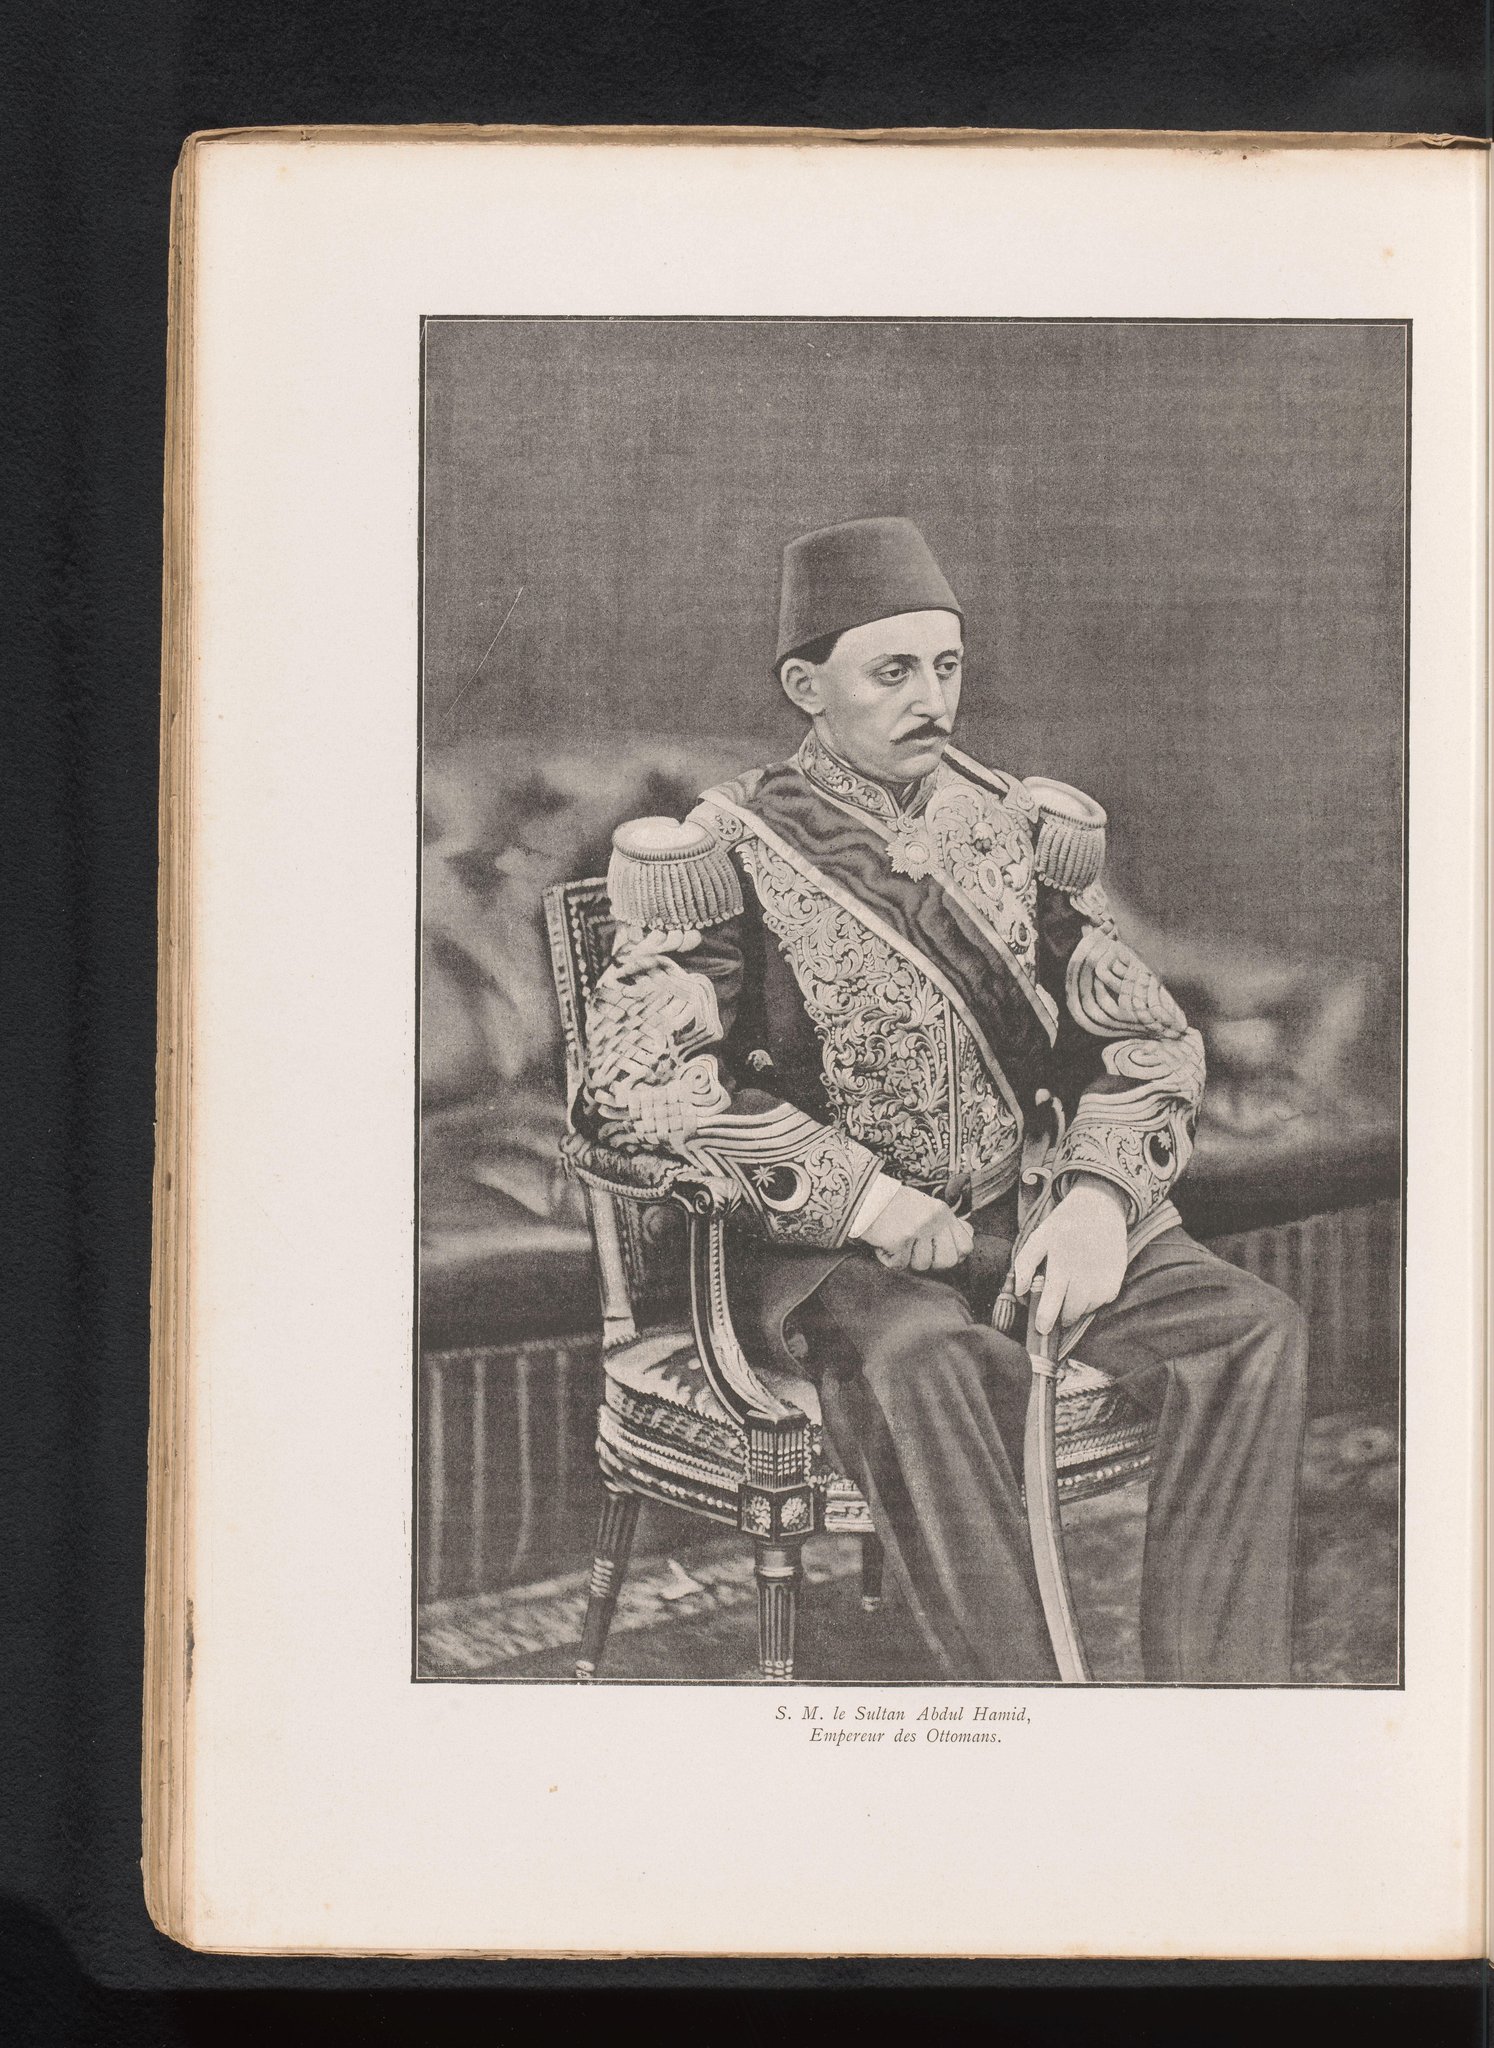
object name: photomechanical print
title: S. M. le Sultan Abdul Hamid, Empereur des Ottomans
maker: Anonymous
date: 1880-1885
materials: paper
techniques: autotype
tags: other sovereign, historical persons